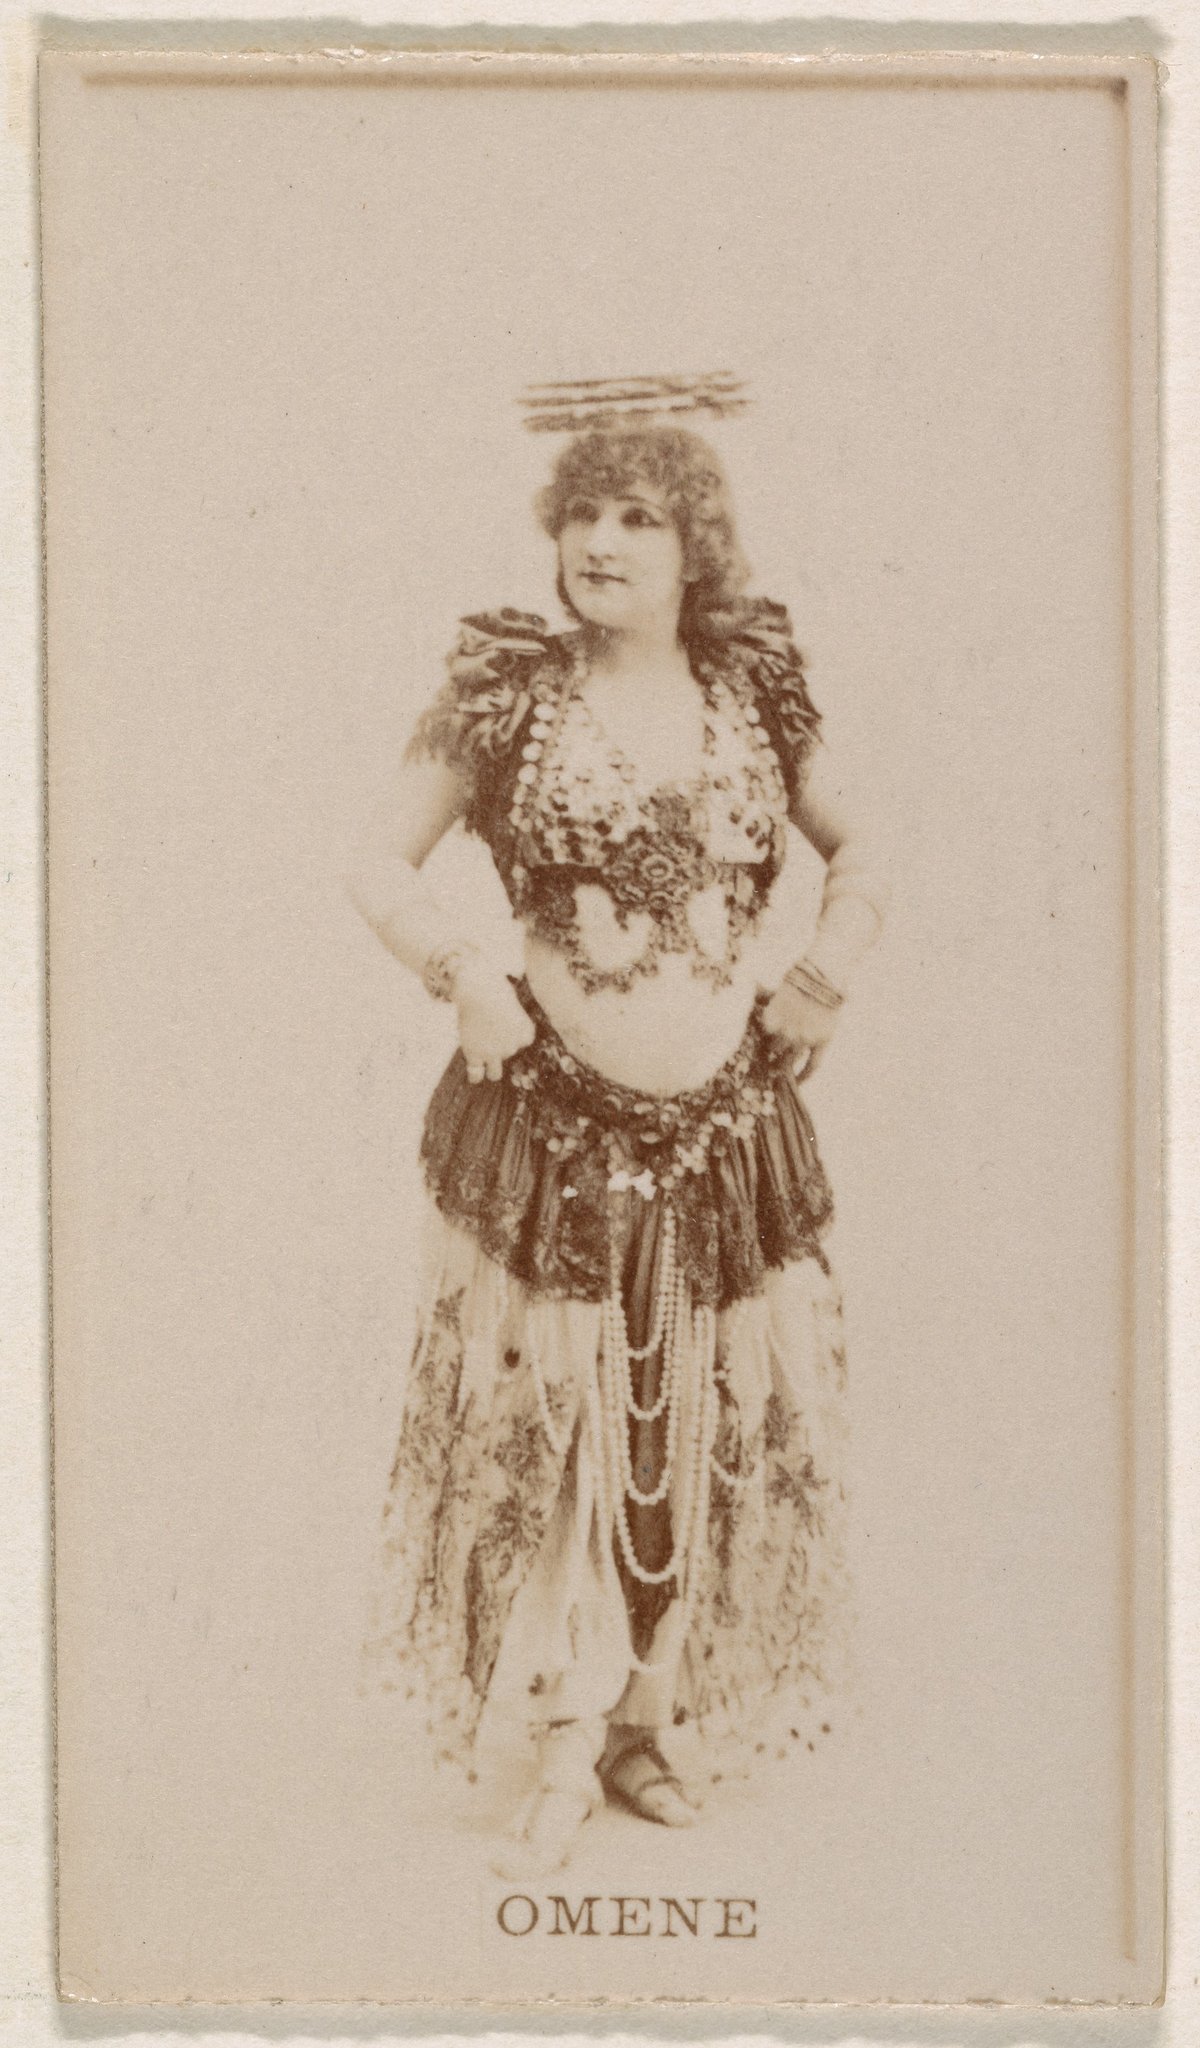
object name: photograph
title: Omene, from the Actresses series (N245) issued by Kinney Brothers to promote Sweet Caporal Cigarettes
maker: kinney brothers tobacco company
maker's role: publisher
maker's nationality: american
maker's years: 1869-2011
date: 1890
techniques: albumen silver print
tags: portraits,women,actresses